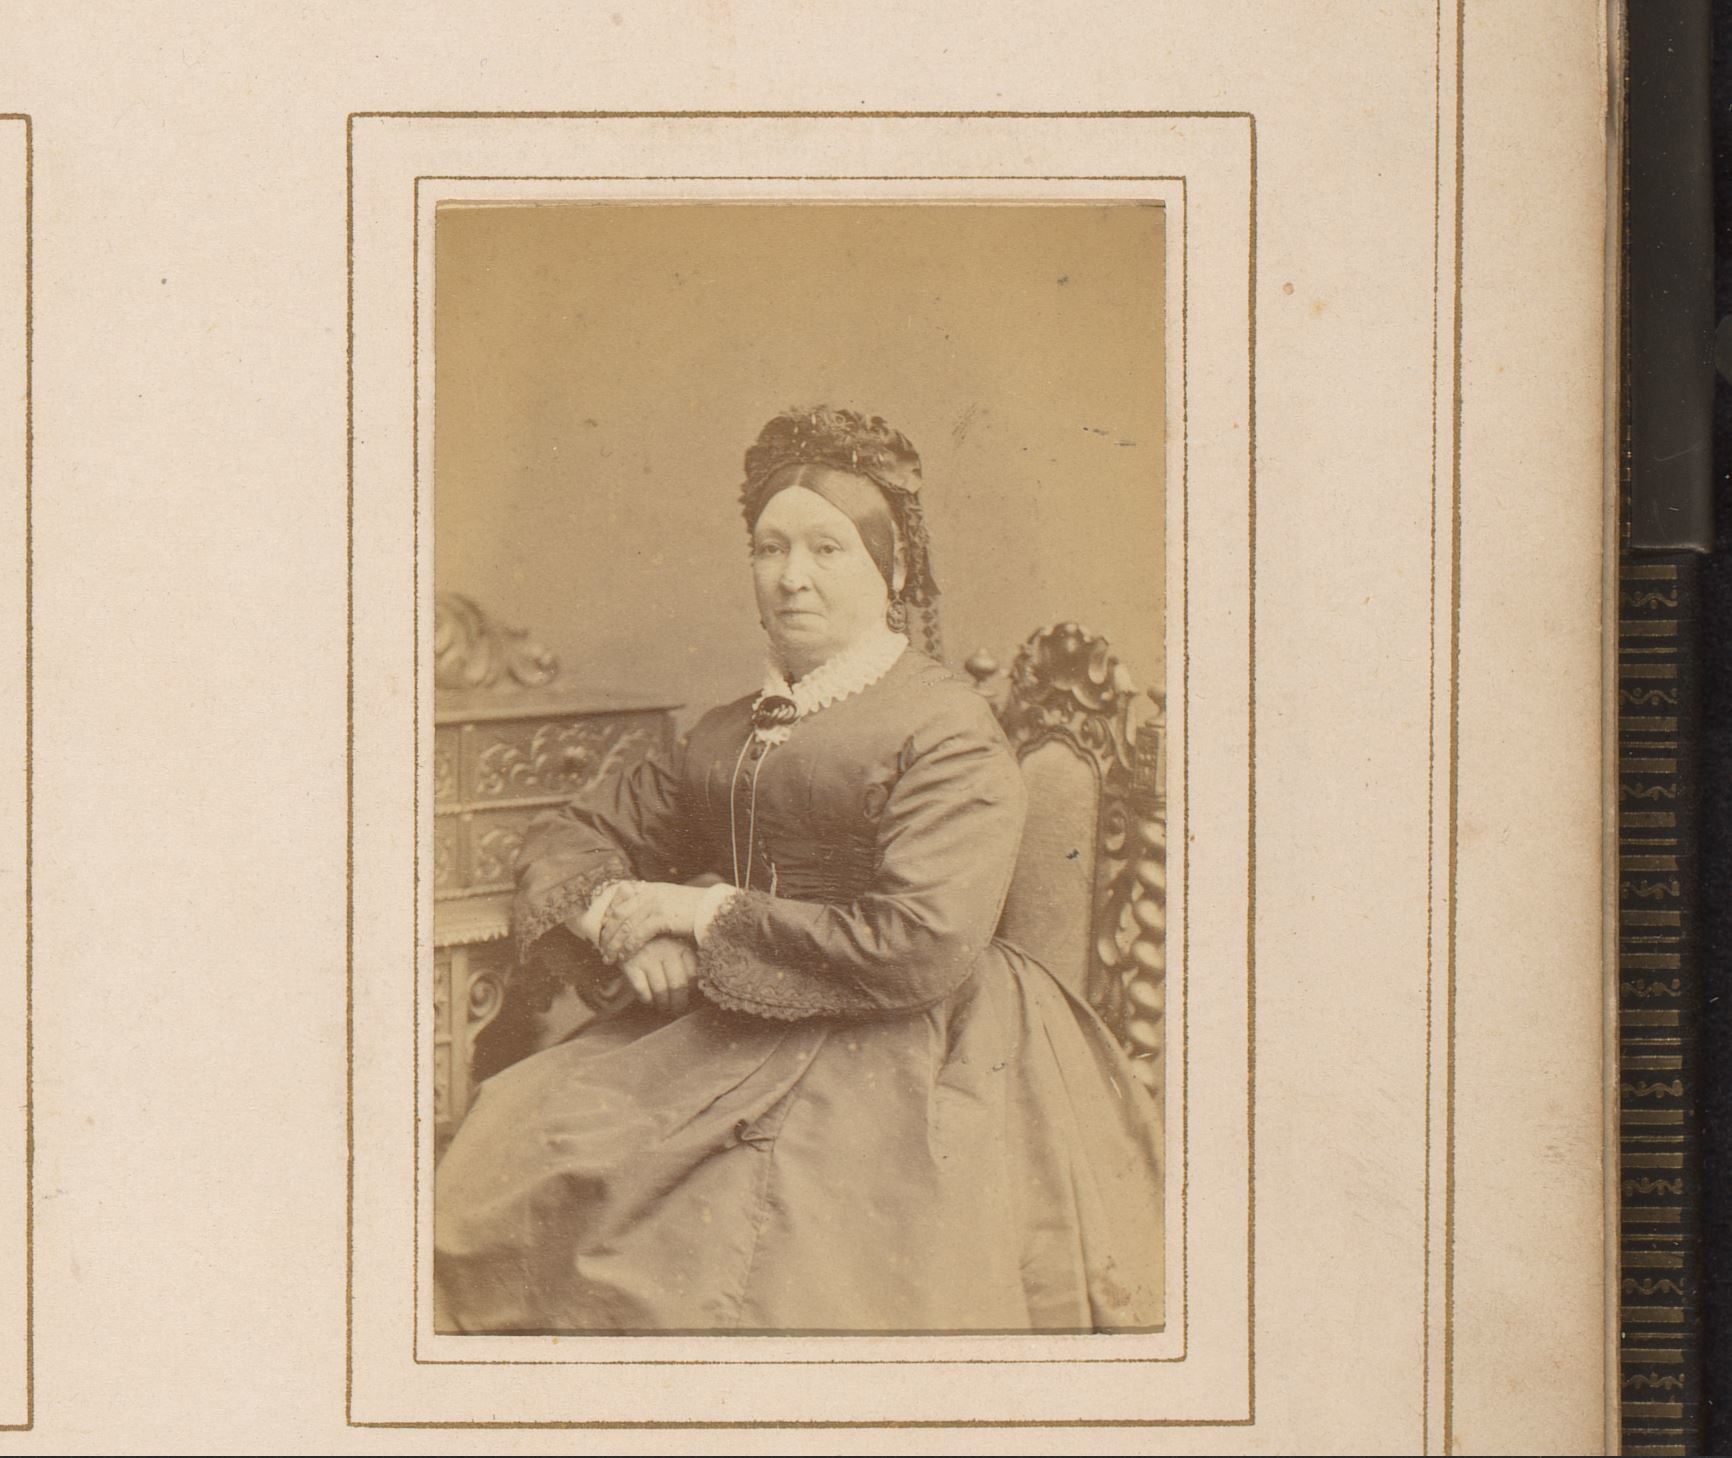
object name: photograph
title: Portret van een zittende vrouw met muts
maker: albert greiner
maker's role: fotograaf, fotostudio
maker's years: 1833-1890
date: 1861-1874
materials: cardboard, photographic support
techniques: albumen print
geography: amsterdam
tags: girl (child between toddler and youth), head-gear: cap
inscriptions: inscription: ‘A. Greiner/ Photograf/ Nieuwendijk L.87/ Amsterdam’